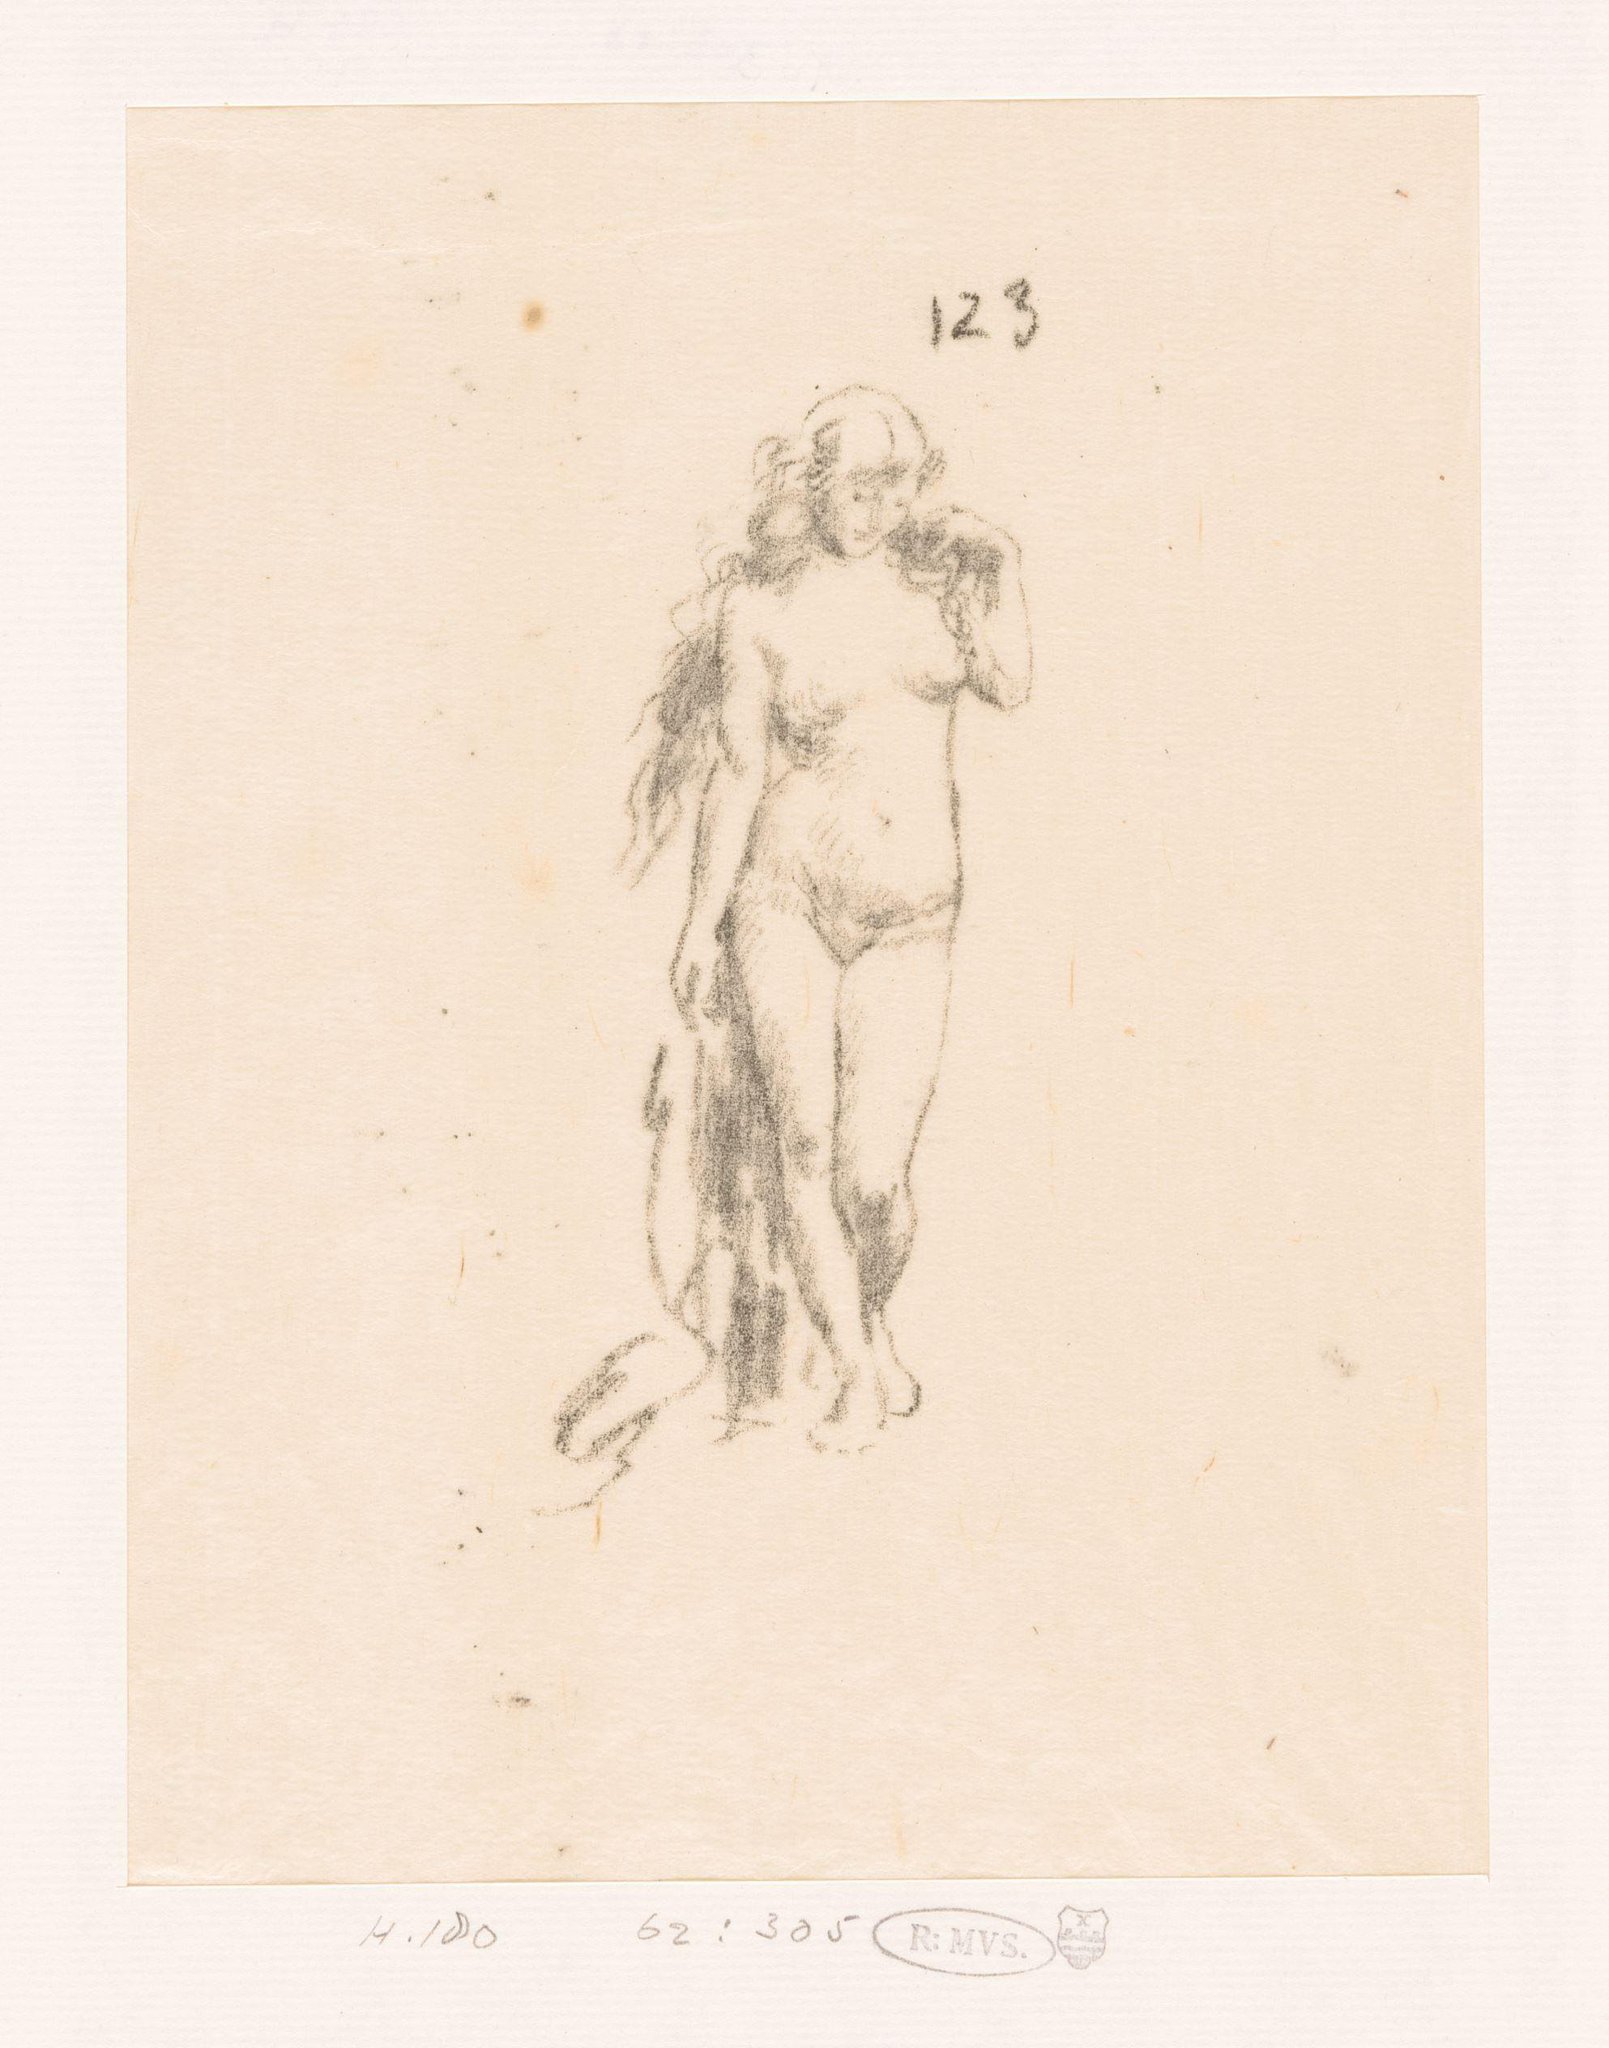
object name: print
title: Studie van een naakte vrouw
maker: henri fantin-latour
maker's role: draughtsman, print maker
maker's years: 1836-1904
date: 1846-1904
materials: paper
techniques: lithography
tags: woman (showing herself) undressed, quasi-nude, the (nude) human figure; 'corpo humano' (ripa) - aa - female human figure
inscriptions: collector's mark: Lugt 2760, collector's mark: Lugt 2228a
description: Het blad is een fragment van de hele prent.